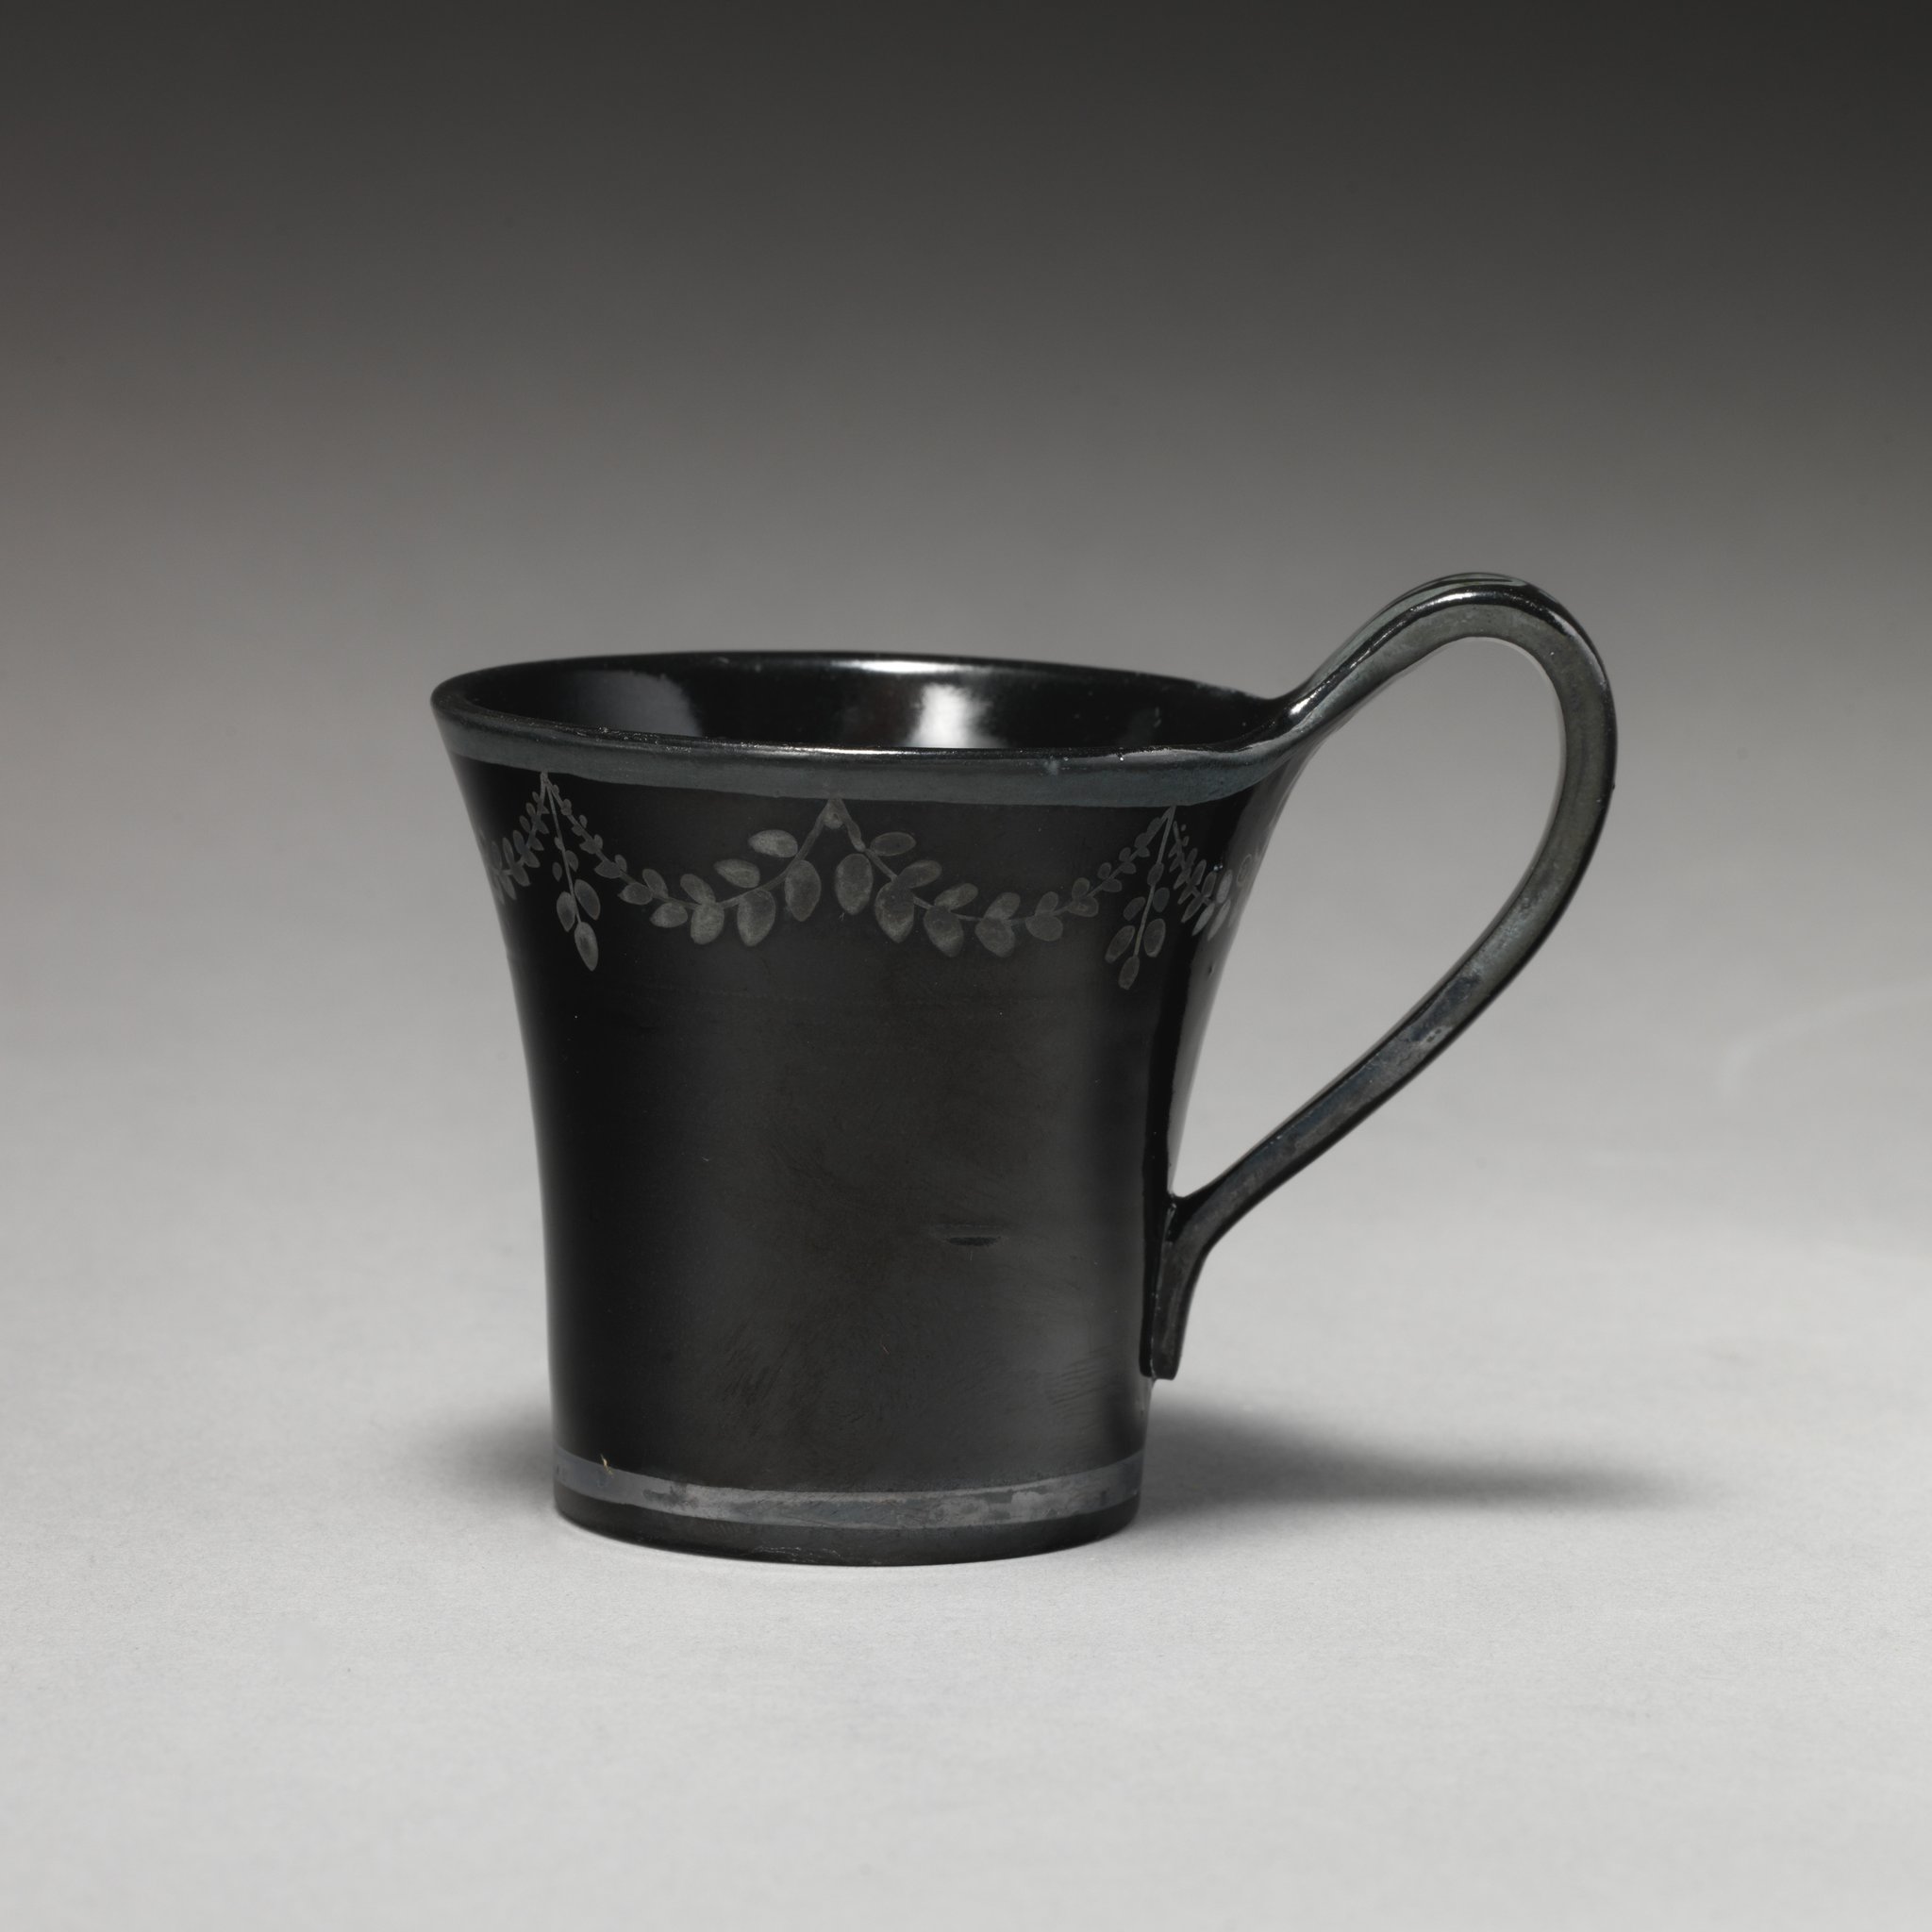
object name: coffee cup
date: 1801-1833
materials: pottery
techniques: glazing